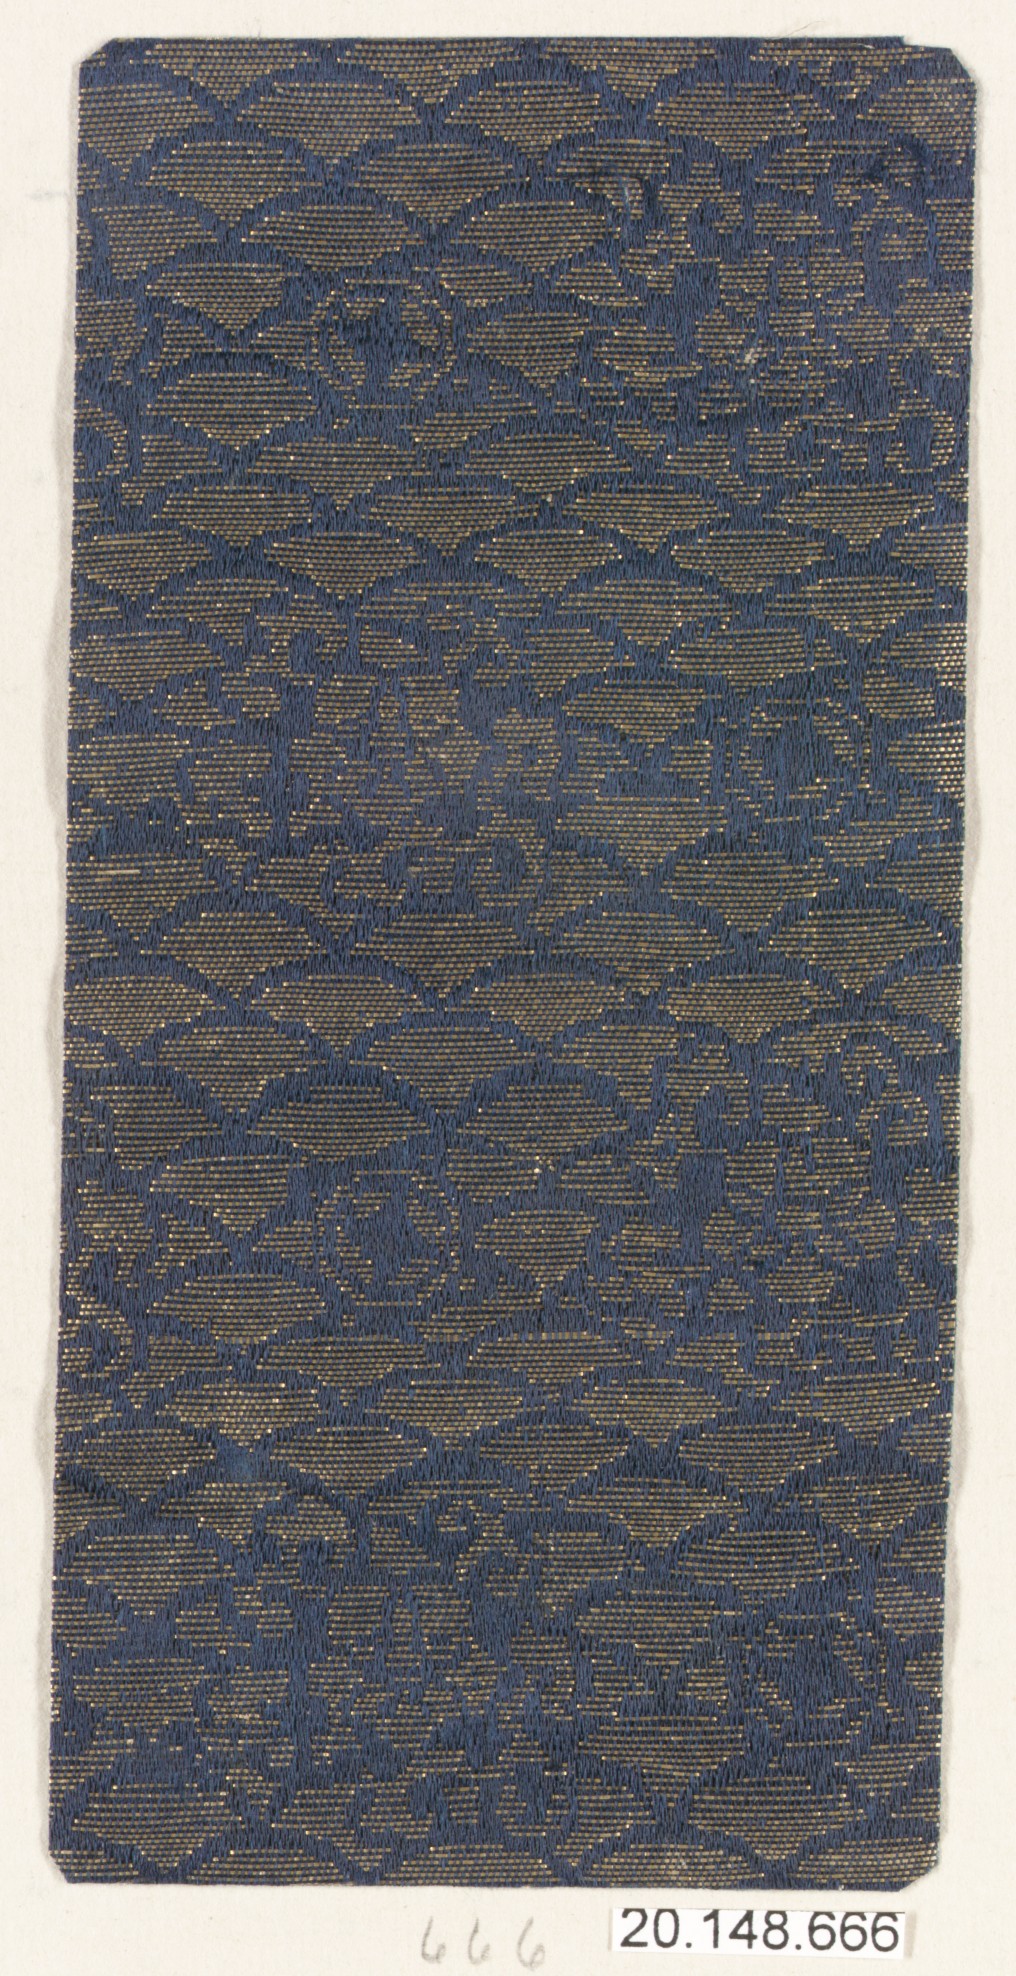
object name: piece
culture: japanese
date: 1701-1800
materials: silk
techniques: compound weave